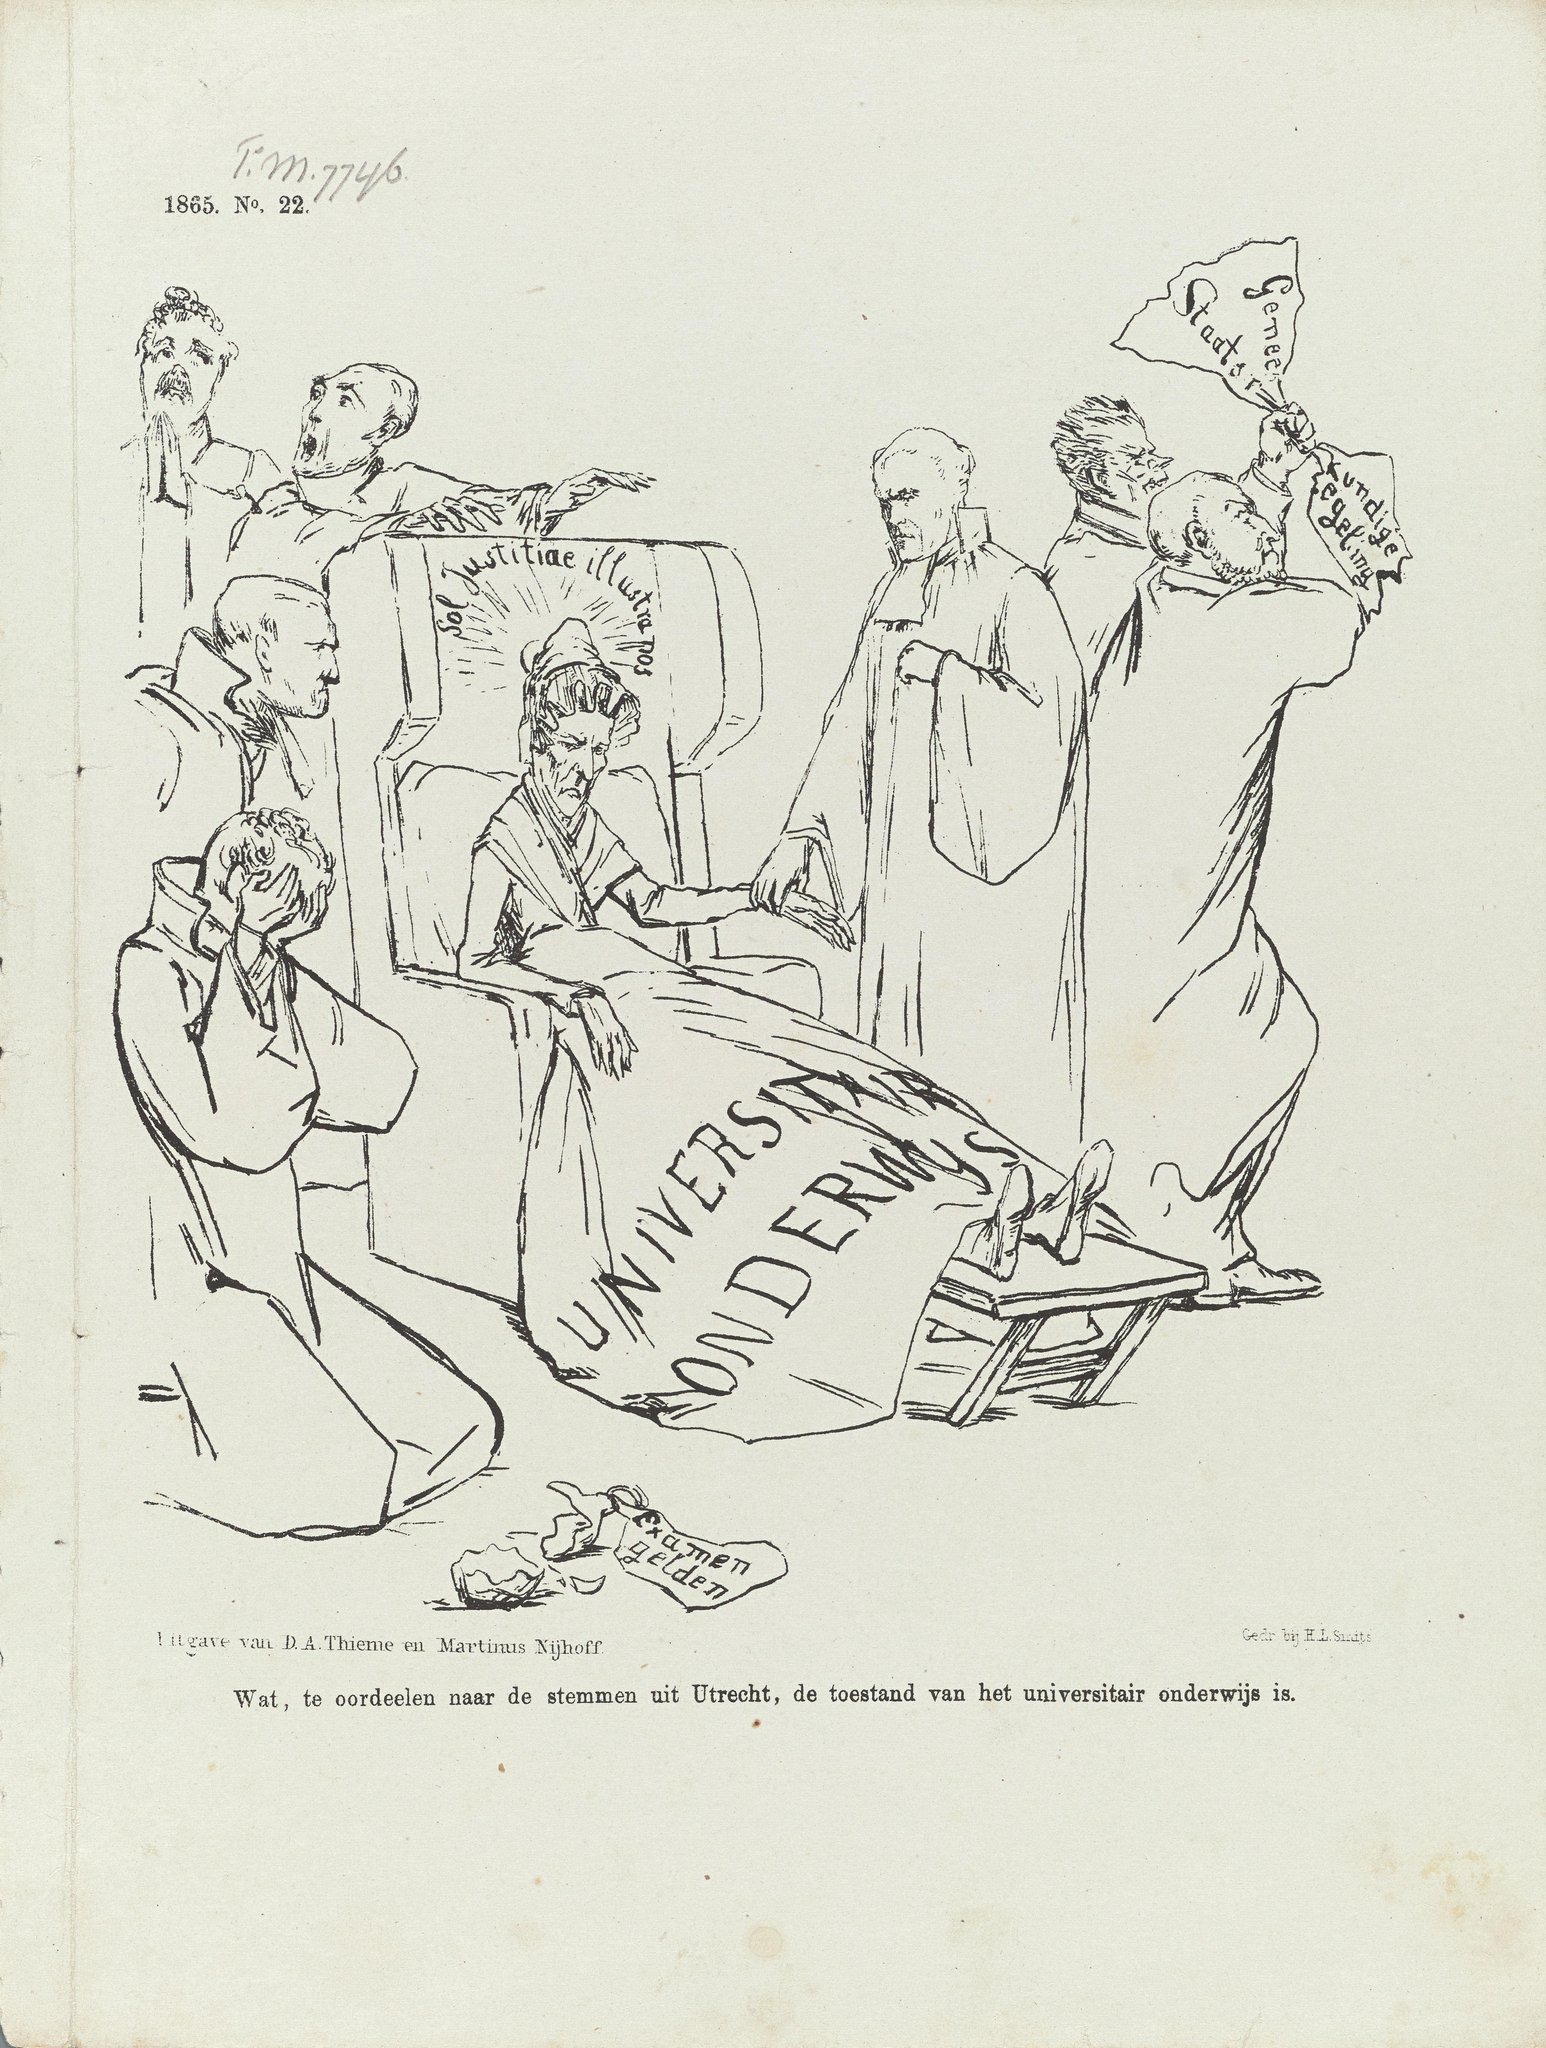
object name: cartoon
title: Spotprent op de toestand aan de universiteiten, 1865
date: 1865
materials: paper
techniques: lithograph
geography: netherlands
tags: university education, examination, diagnosis; physician speaking with patient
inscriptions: collector's mark: Lugt 2228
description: Spotprent op de slechte toestand van de universiteiten. Een vrouw 'universitair onderwijs' ligt doodziek in een stoel, om haar heen wanhopige artsen. Plaat verschenen bij het weekblad De Nederlandsche Spectator, nr. 22, 3 juni 1865.